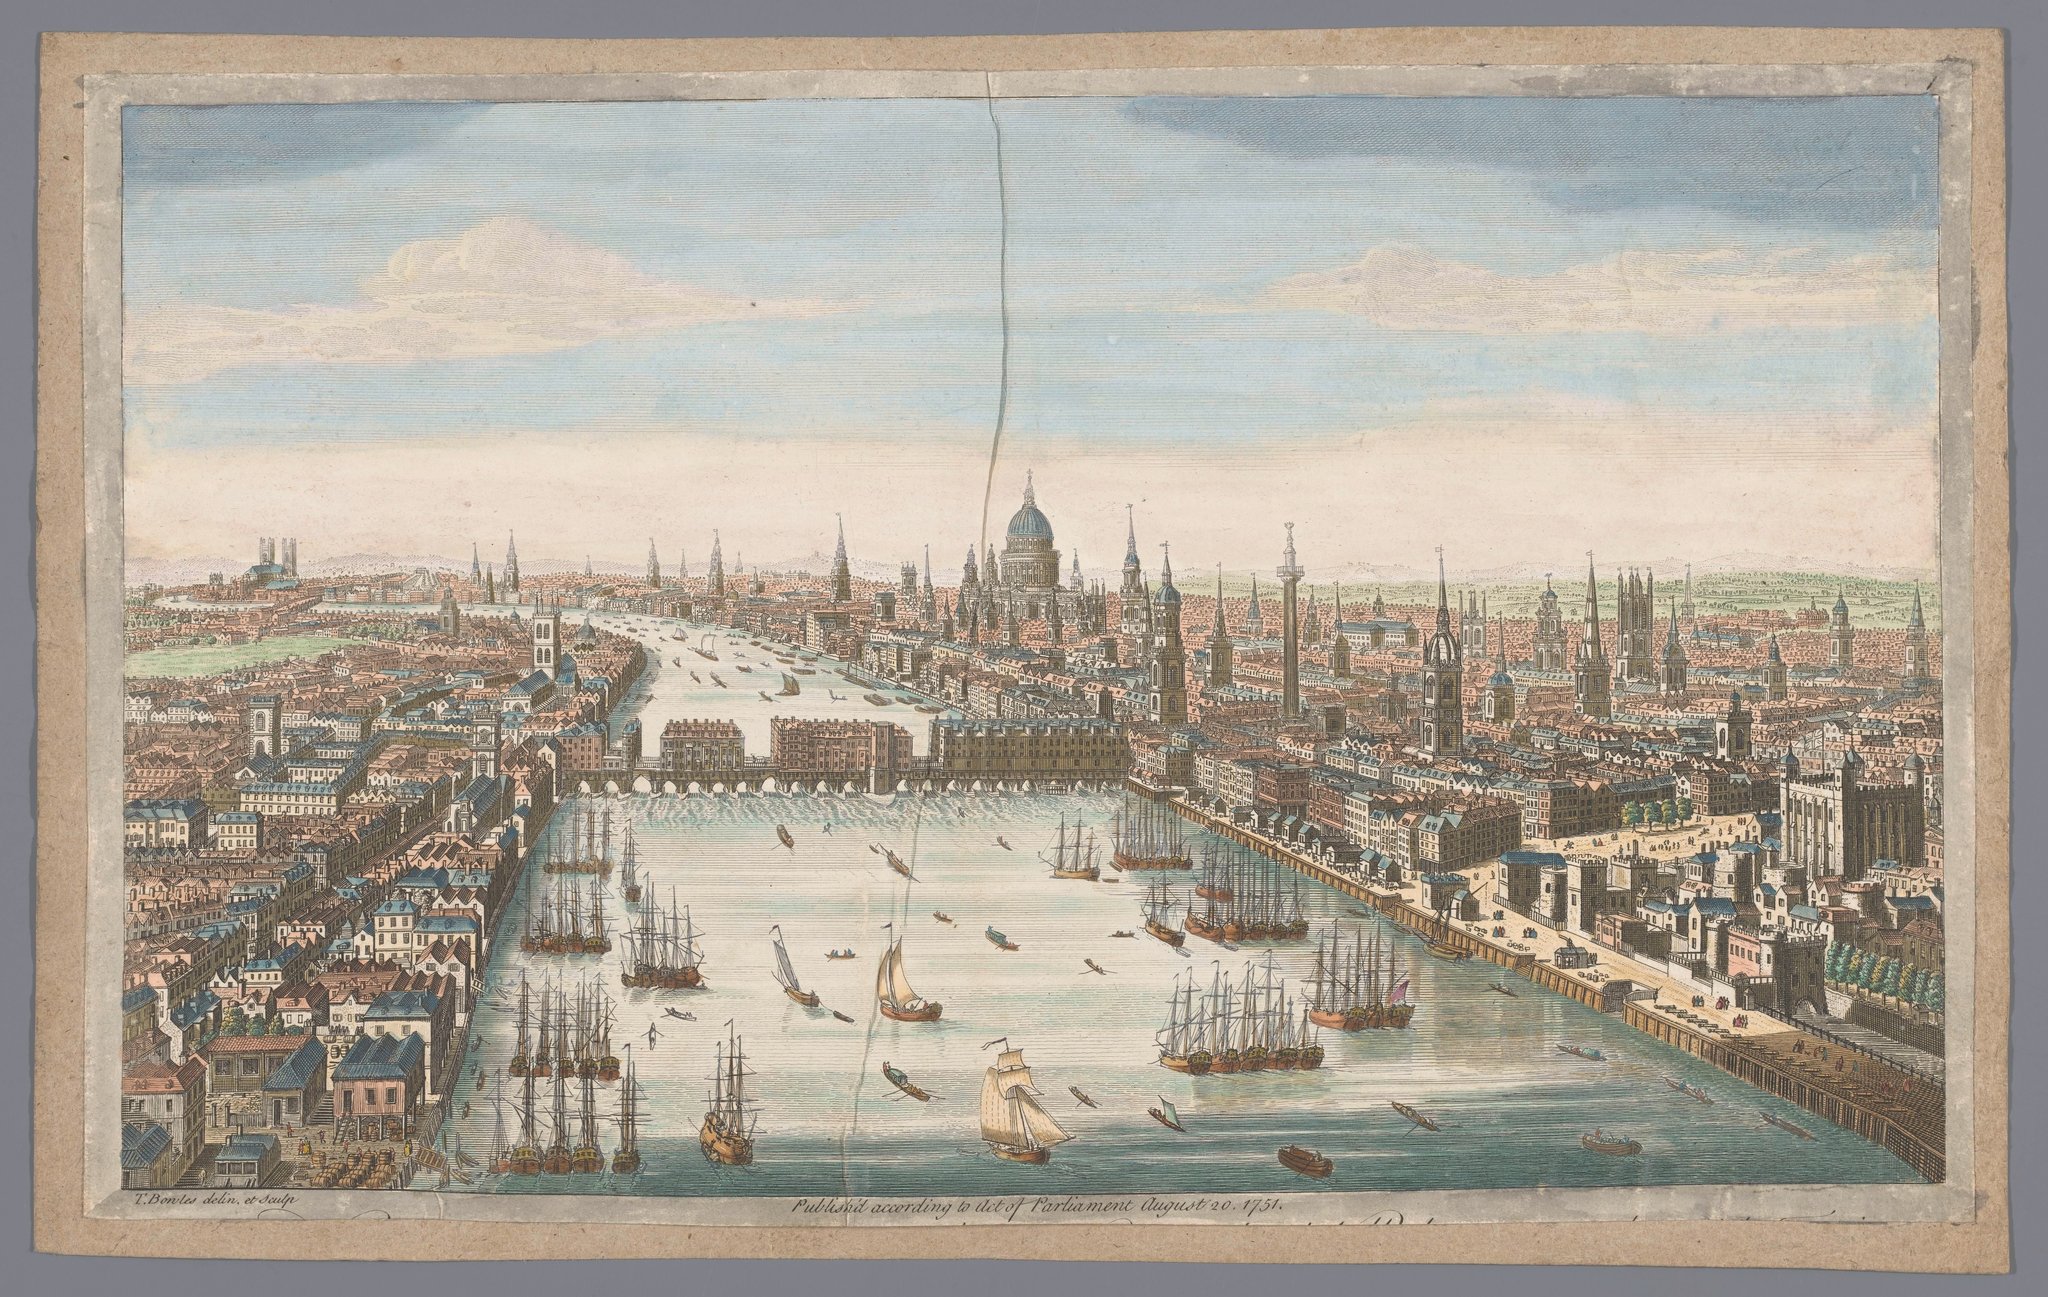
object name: print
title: A general view of the city of London, next the river Thames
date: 1751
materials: cardboard, paper, watercolor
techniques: brush, etching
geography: london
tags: bridge in city across river, canal, etc. (+ city(-scape) with figures, staffage), sailing-ship, sailing-boat, church (exterior), city-view in general; 'veduta' (+ city(-scape) with figures, staffage), westminster abbey, london, thames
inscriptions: collector's mark: Lugt 2233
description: In het midden een bebouwde brug over de rivier de Theems en Saint Paul's Cathedral. Op de achtergrond links Westminster Abbey. Rechtsboven genummerd: 1.